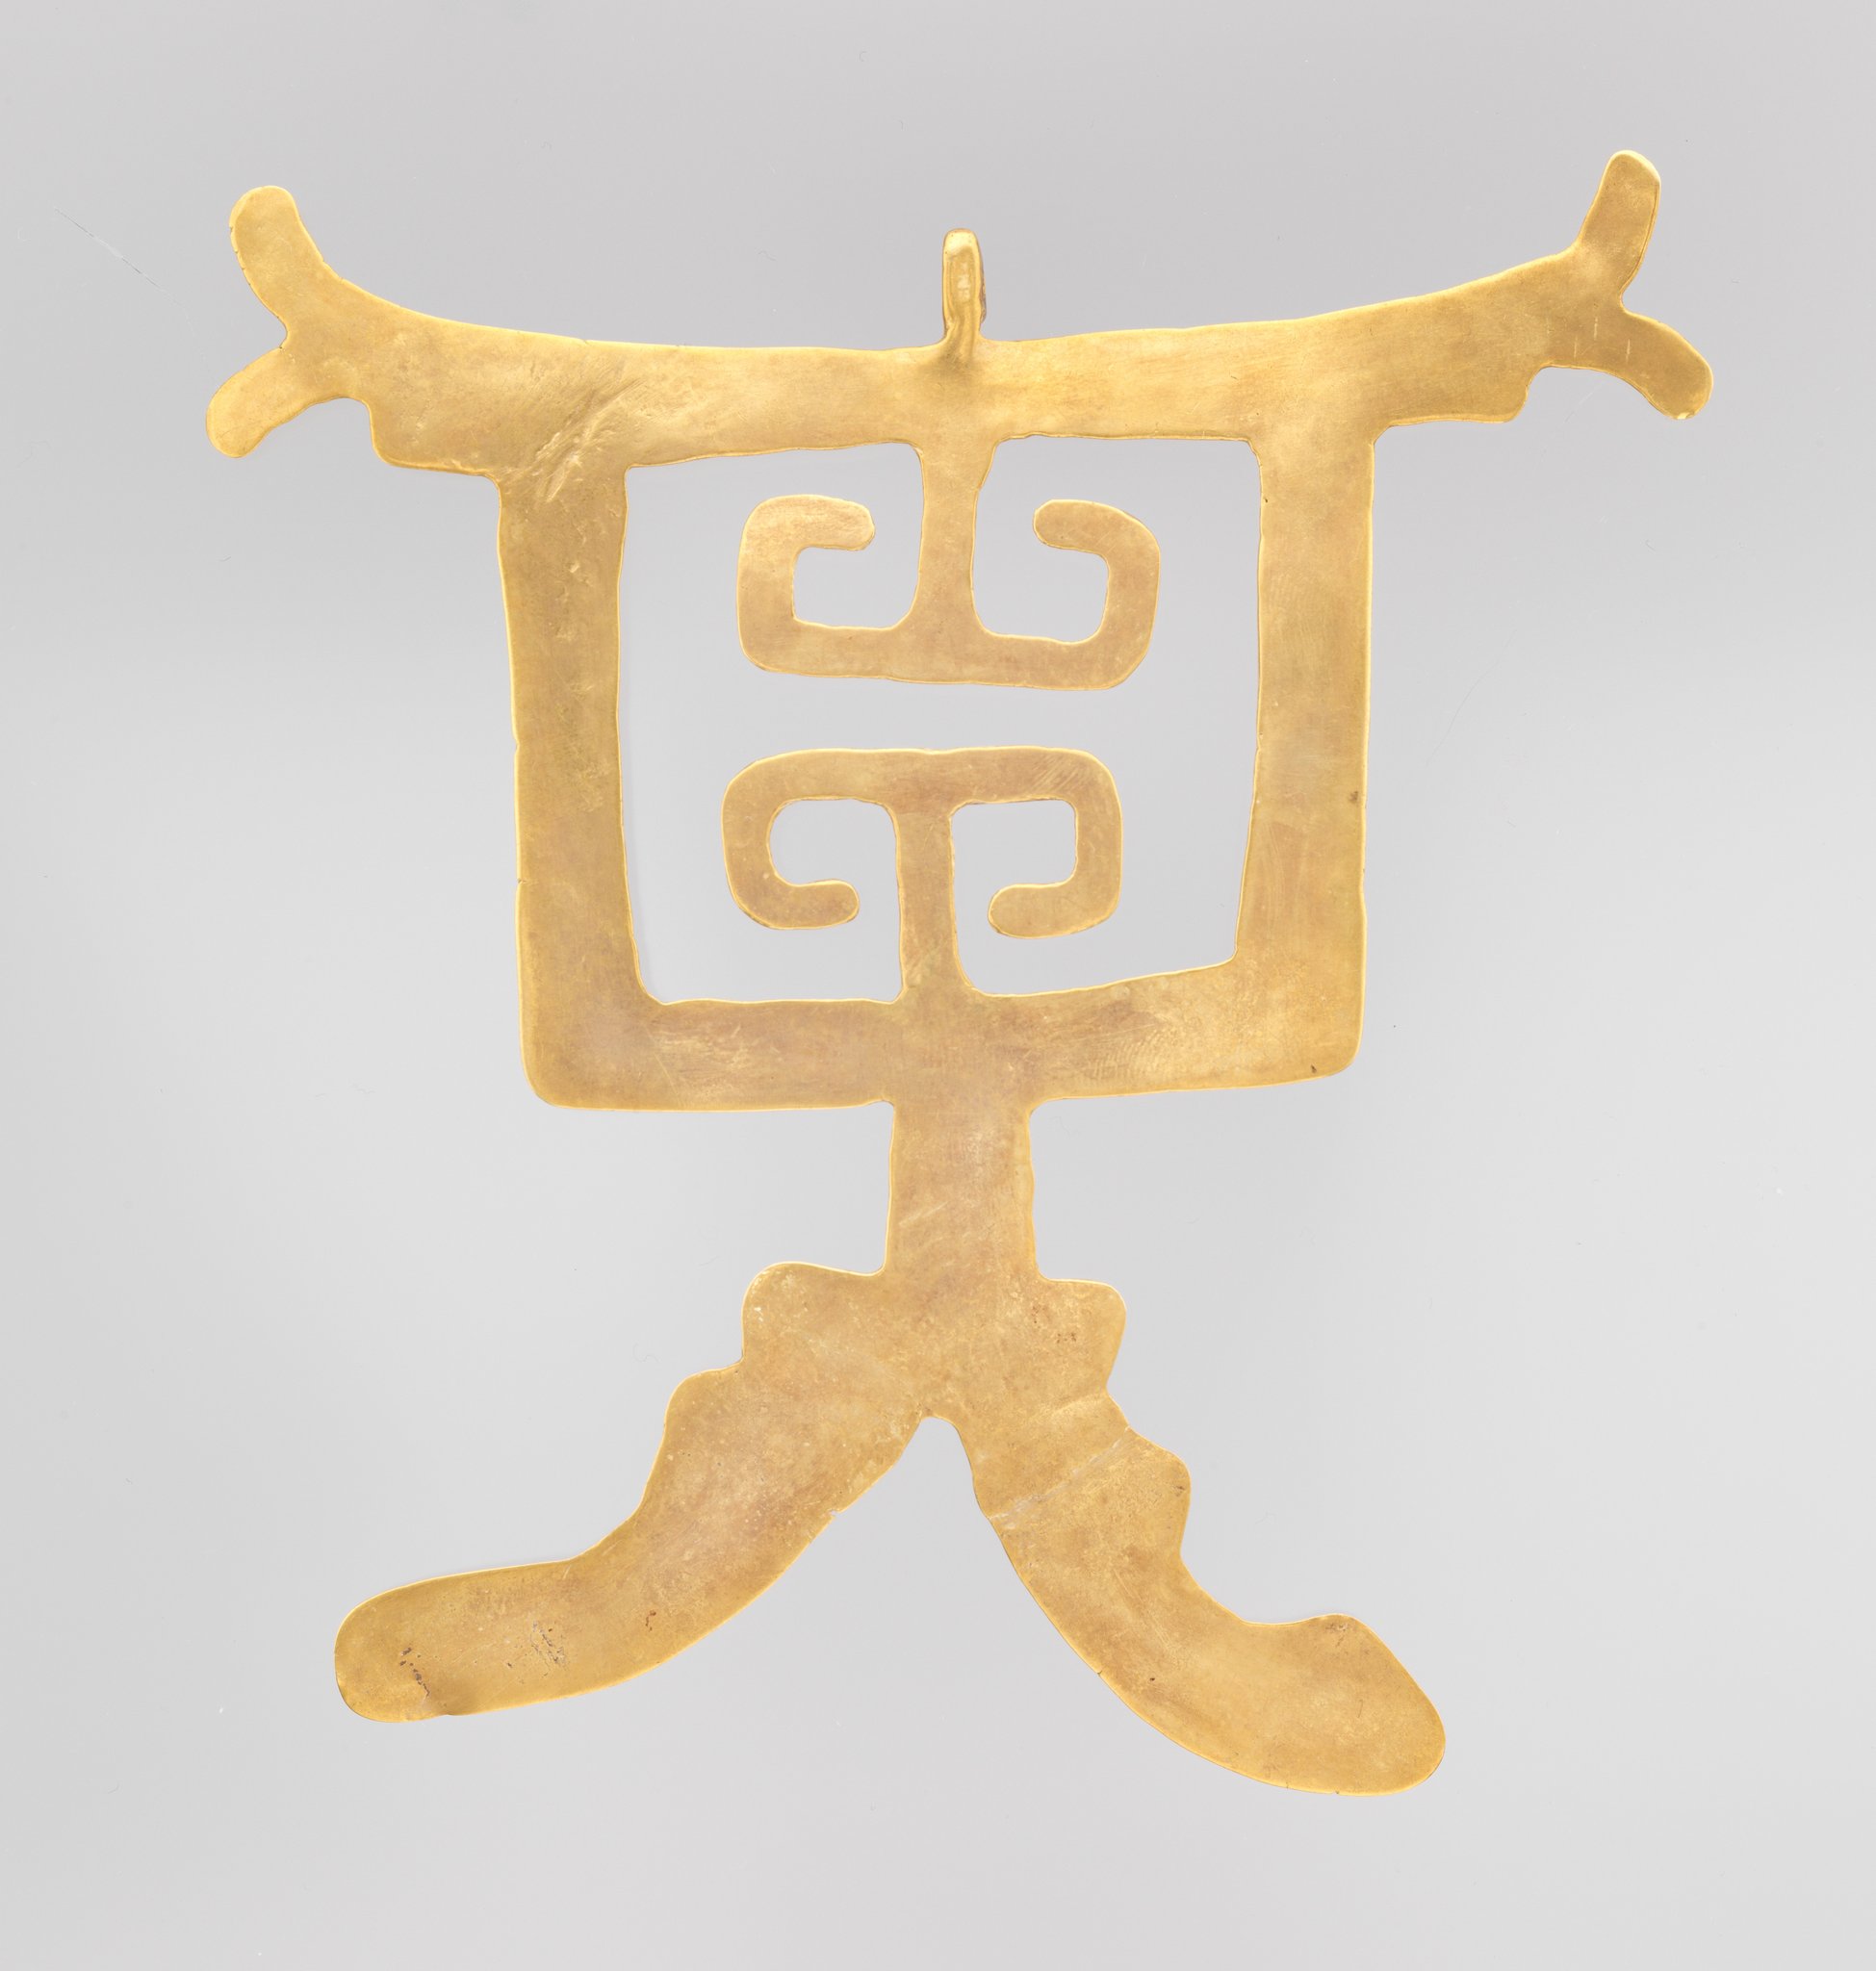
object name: pendant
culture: capulí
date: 301-1000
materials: gold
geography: colombia